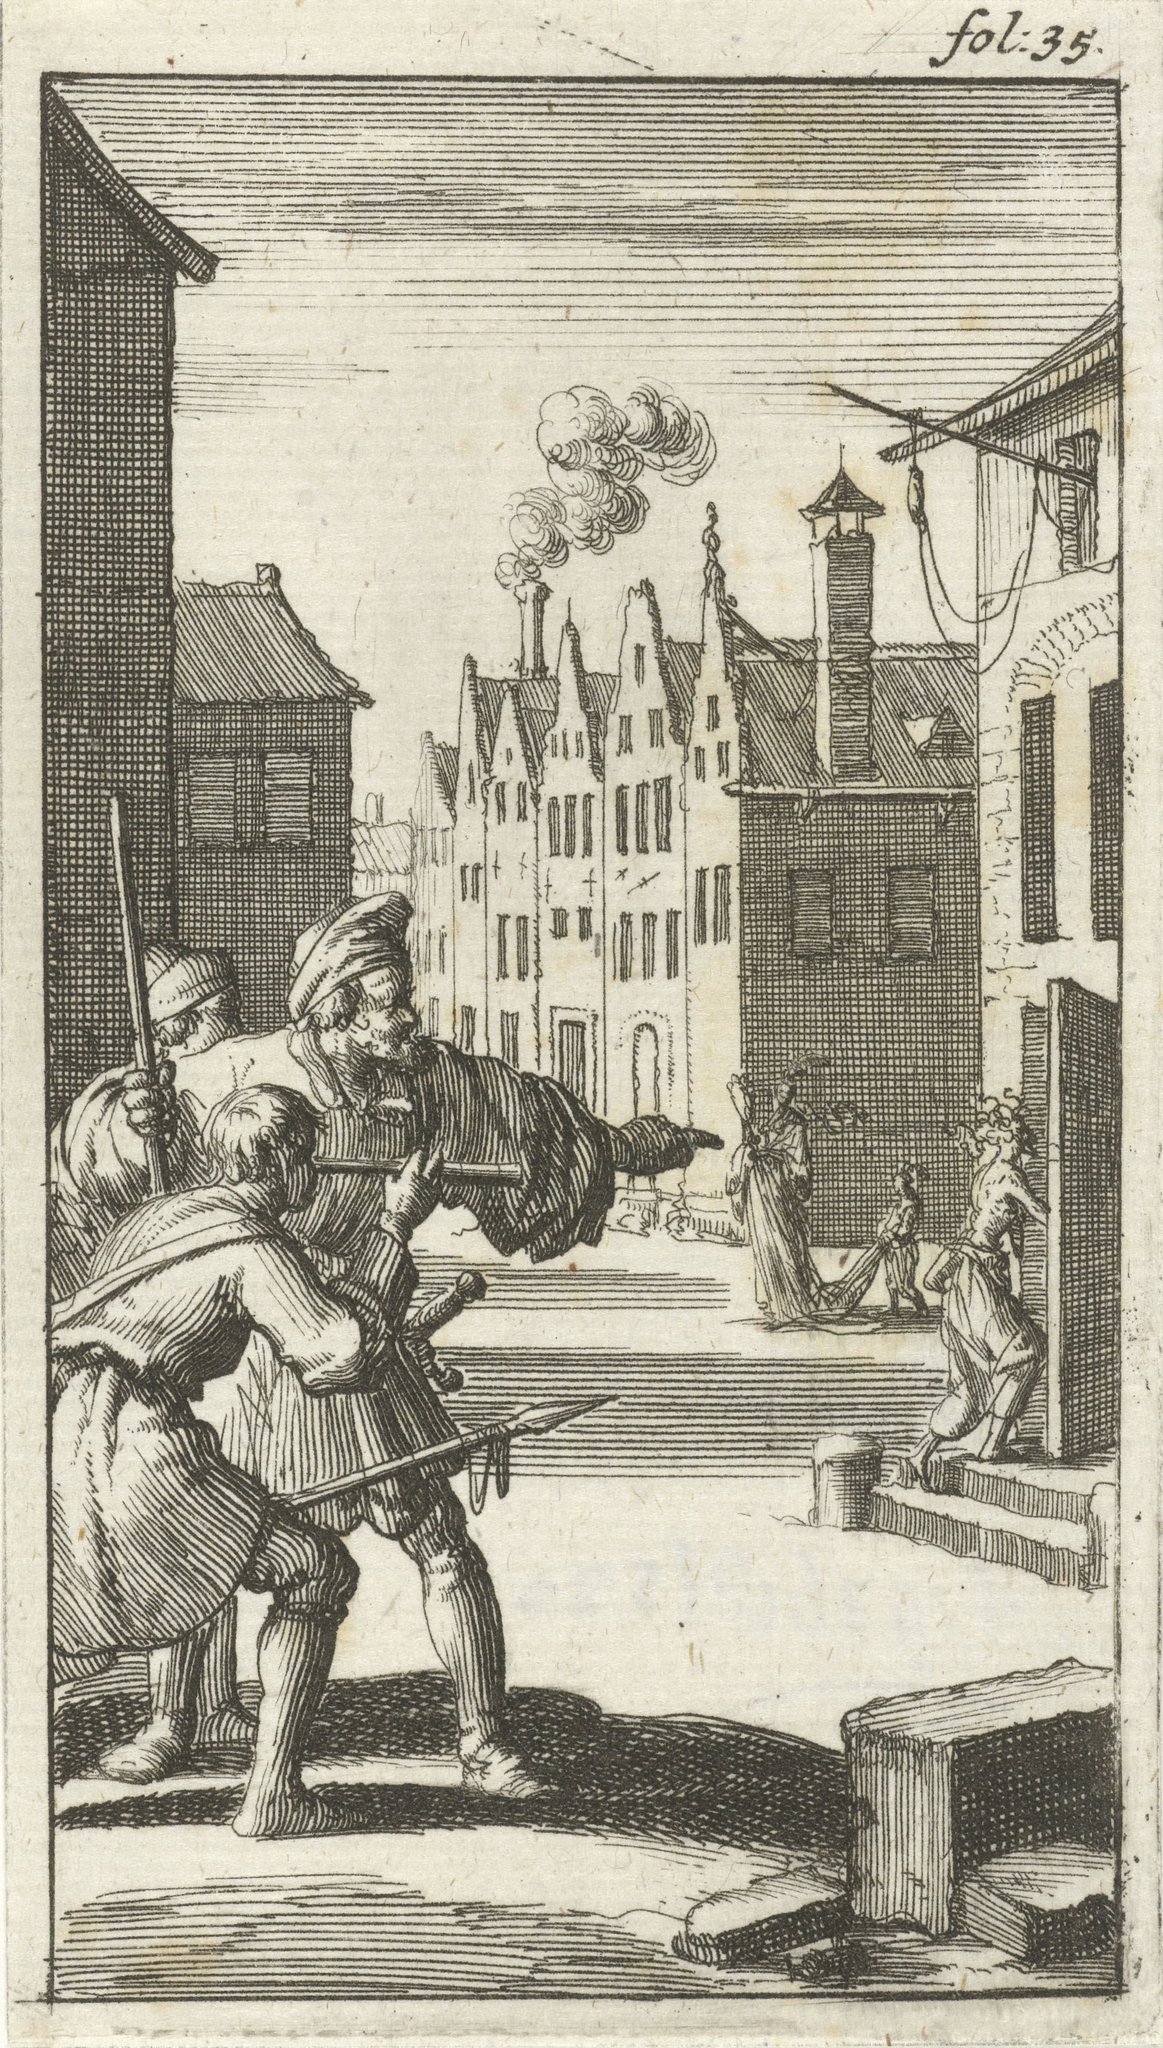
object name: print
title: Drie mannen zien de Zonde een huis binnentreden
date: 1687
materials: paper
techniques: etching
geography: amsterdam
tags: the seven deadly sins (personified)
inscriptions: collector's mark: Lugt 2228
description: Illustratie uit: Bernard, Richard. Het menschen-eyland, ofte Rechts-pligtige procedure tegens de sonde, in't raad-huys van 'smenschen-herte. Amsterdam: Abraham Boekholt, 1686.